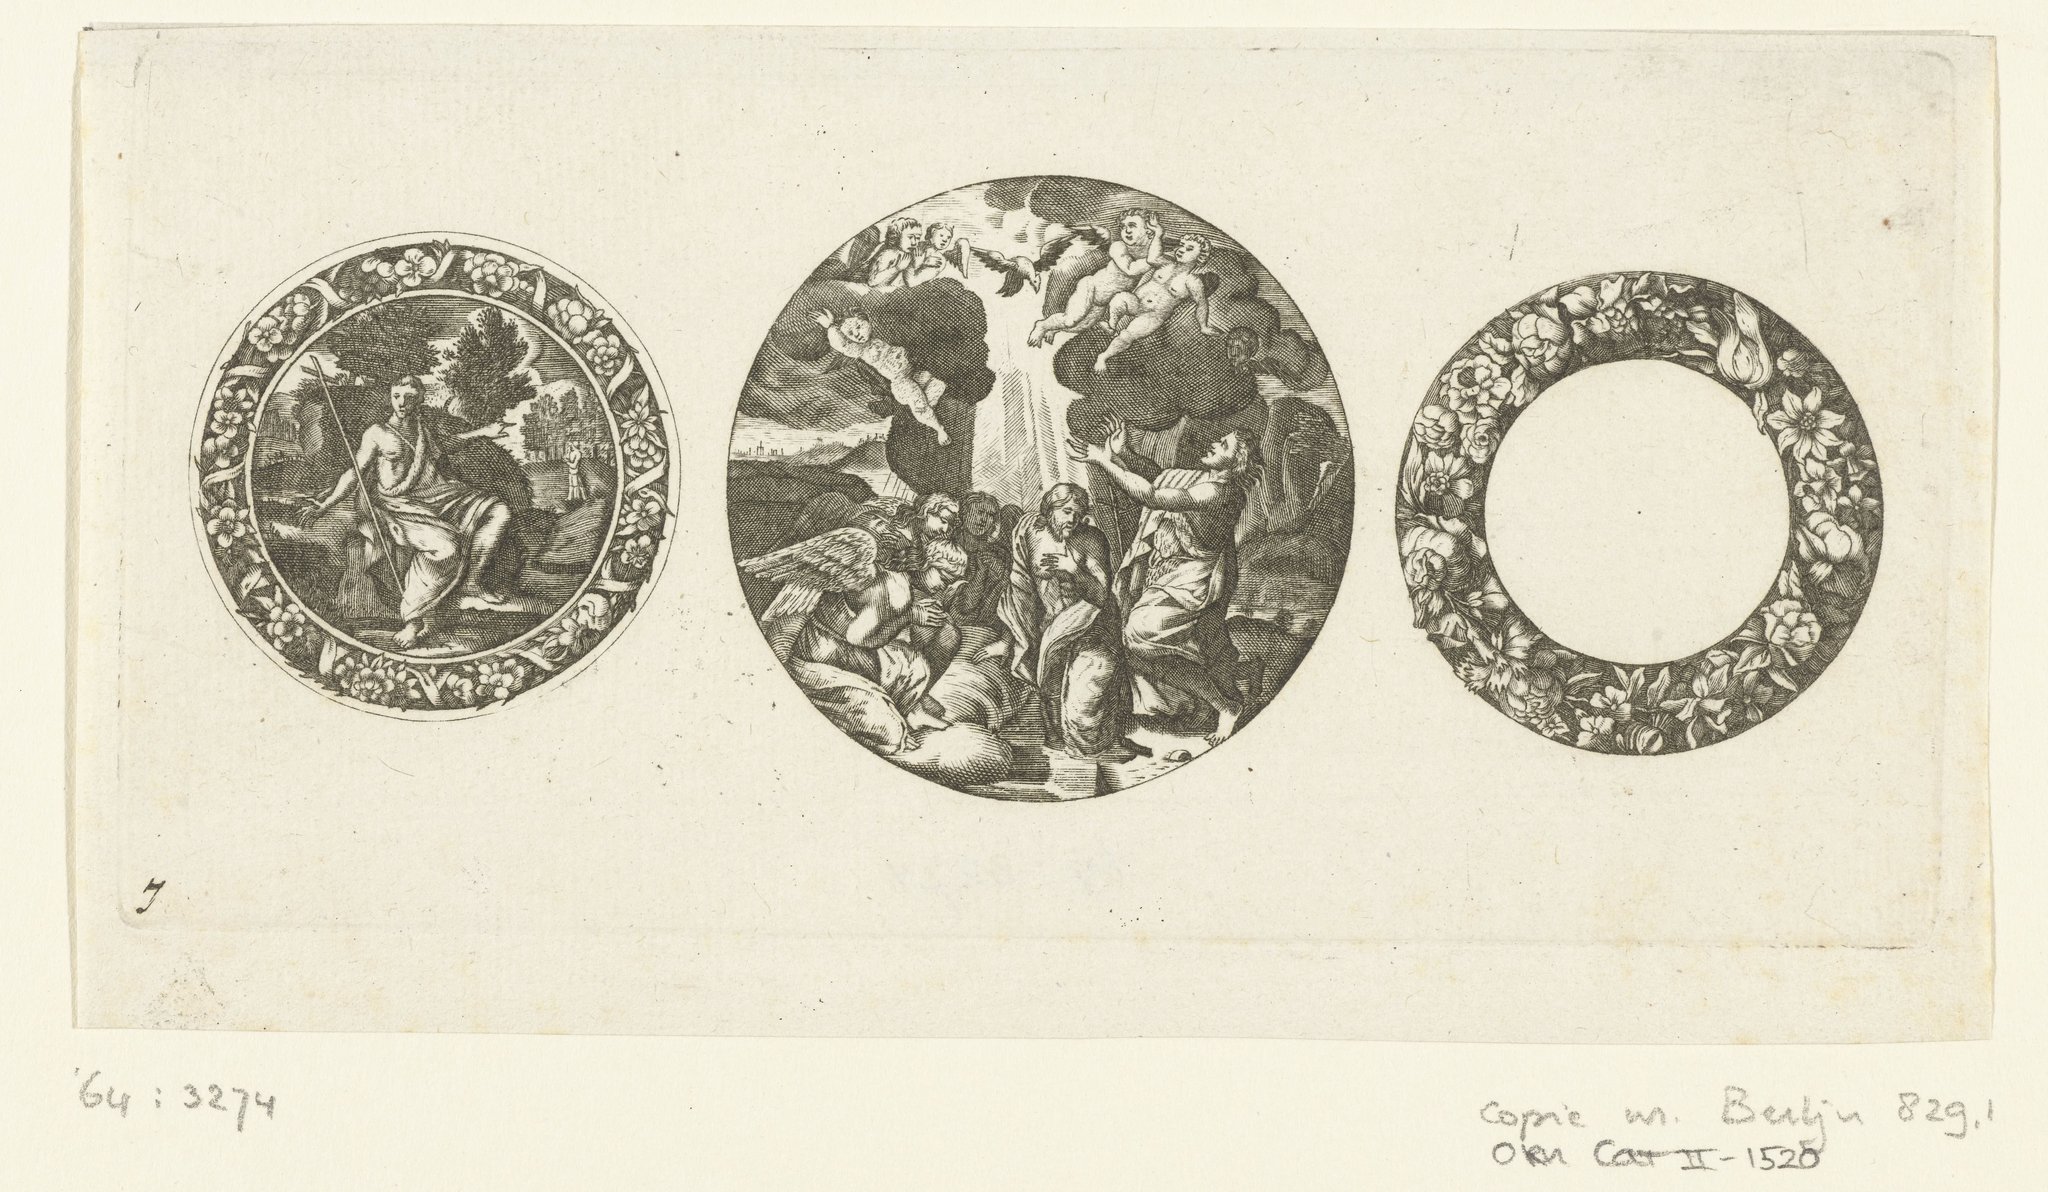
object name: ornament print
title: Horlogekast, medaillon en rand met bloemen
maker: Anonymous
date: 1631-1736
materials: paper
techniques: engraving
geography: netherlands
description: In het midden een horlogekast met de Doop van Christus, links een medaillon met Johannes de Doper omringd door een rand van bloemen.